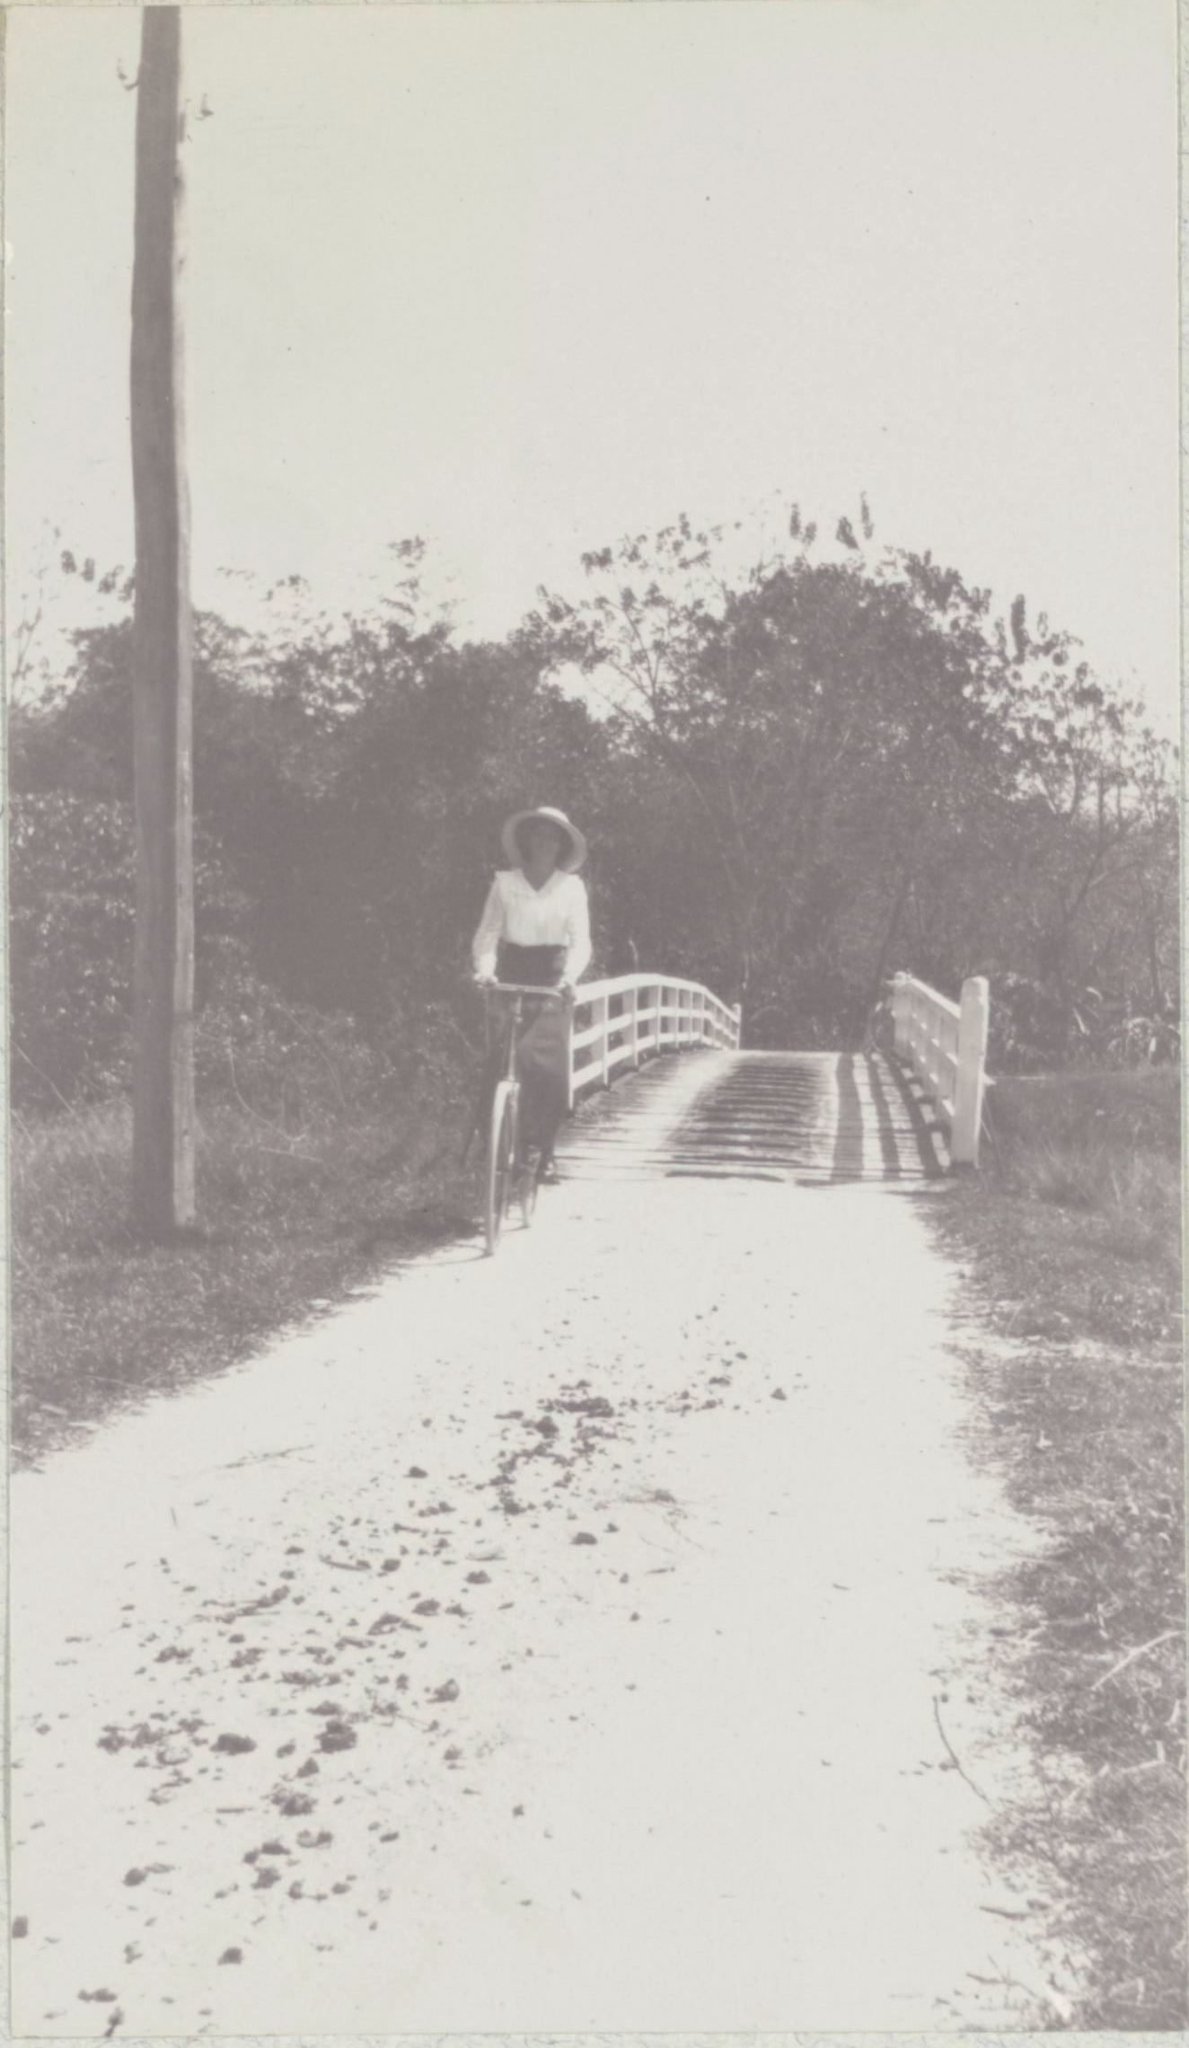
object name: photograph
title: Maria Gonggrijp op de fiets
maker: andries augustus boom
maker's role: amateurfotograaf, handelaar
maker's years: 1878-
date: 1911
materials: photographic support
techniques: photography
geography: suriname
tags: bicycle, suriname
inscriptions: inscription: ‘Clevia 1911’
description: Maria Gonggrijp op de fiets, bij Plantage Clevia 1911. Onderdeel van het fotoalbum van de familie Boom-Gonggrijp in Suriname en Curaçao.